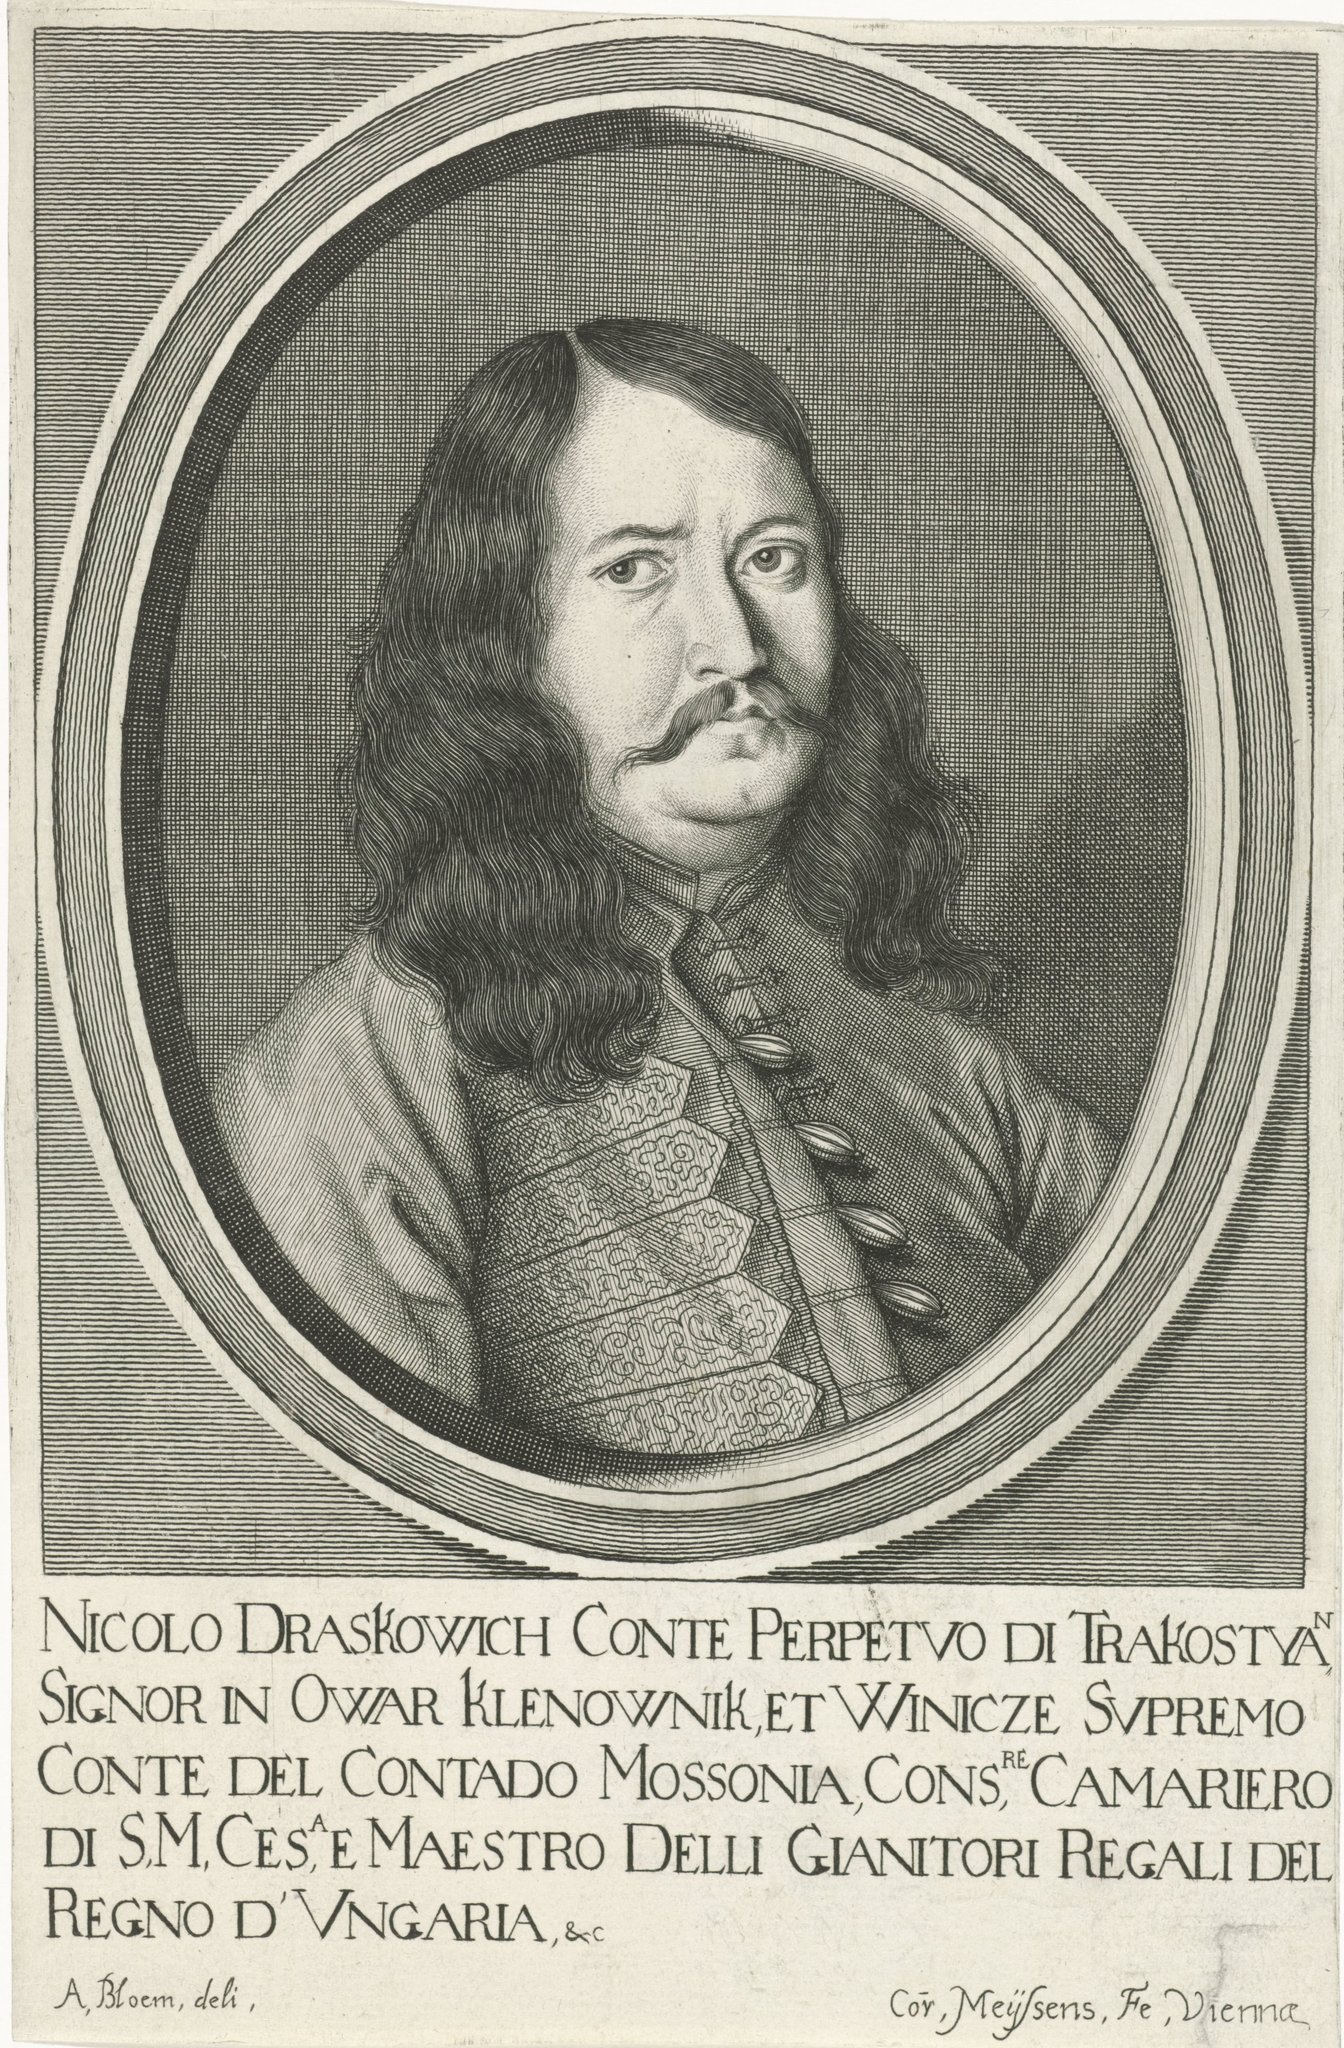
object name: print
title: Portret van Nikola Dras̆ković, graaf van Trakostyáni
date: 1670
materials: paper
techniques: engraving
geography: vienna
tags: nikola dras̆ković (graaf van trakostyáni)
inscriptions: collector's mark: Lugt 2228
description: Prent gebruikt in: Gualdo Priorato, Galeazzo. Historia di Leopoldo Cesare, (...). 3 dln. Wenen, Giovanni Battista Hacque, 1670-1674, dl. 2.